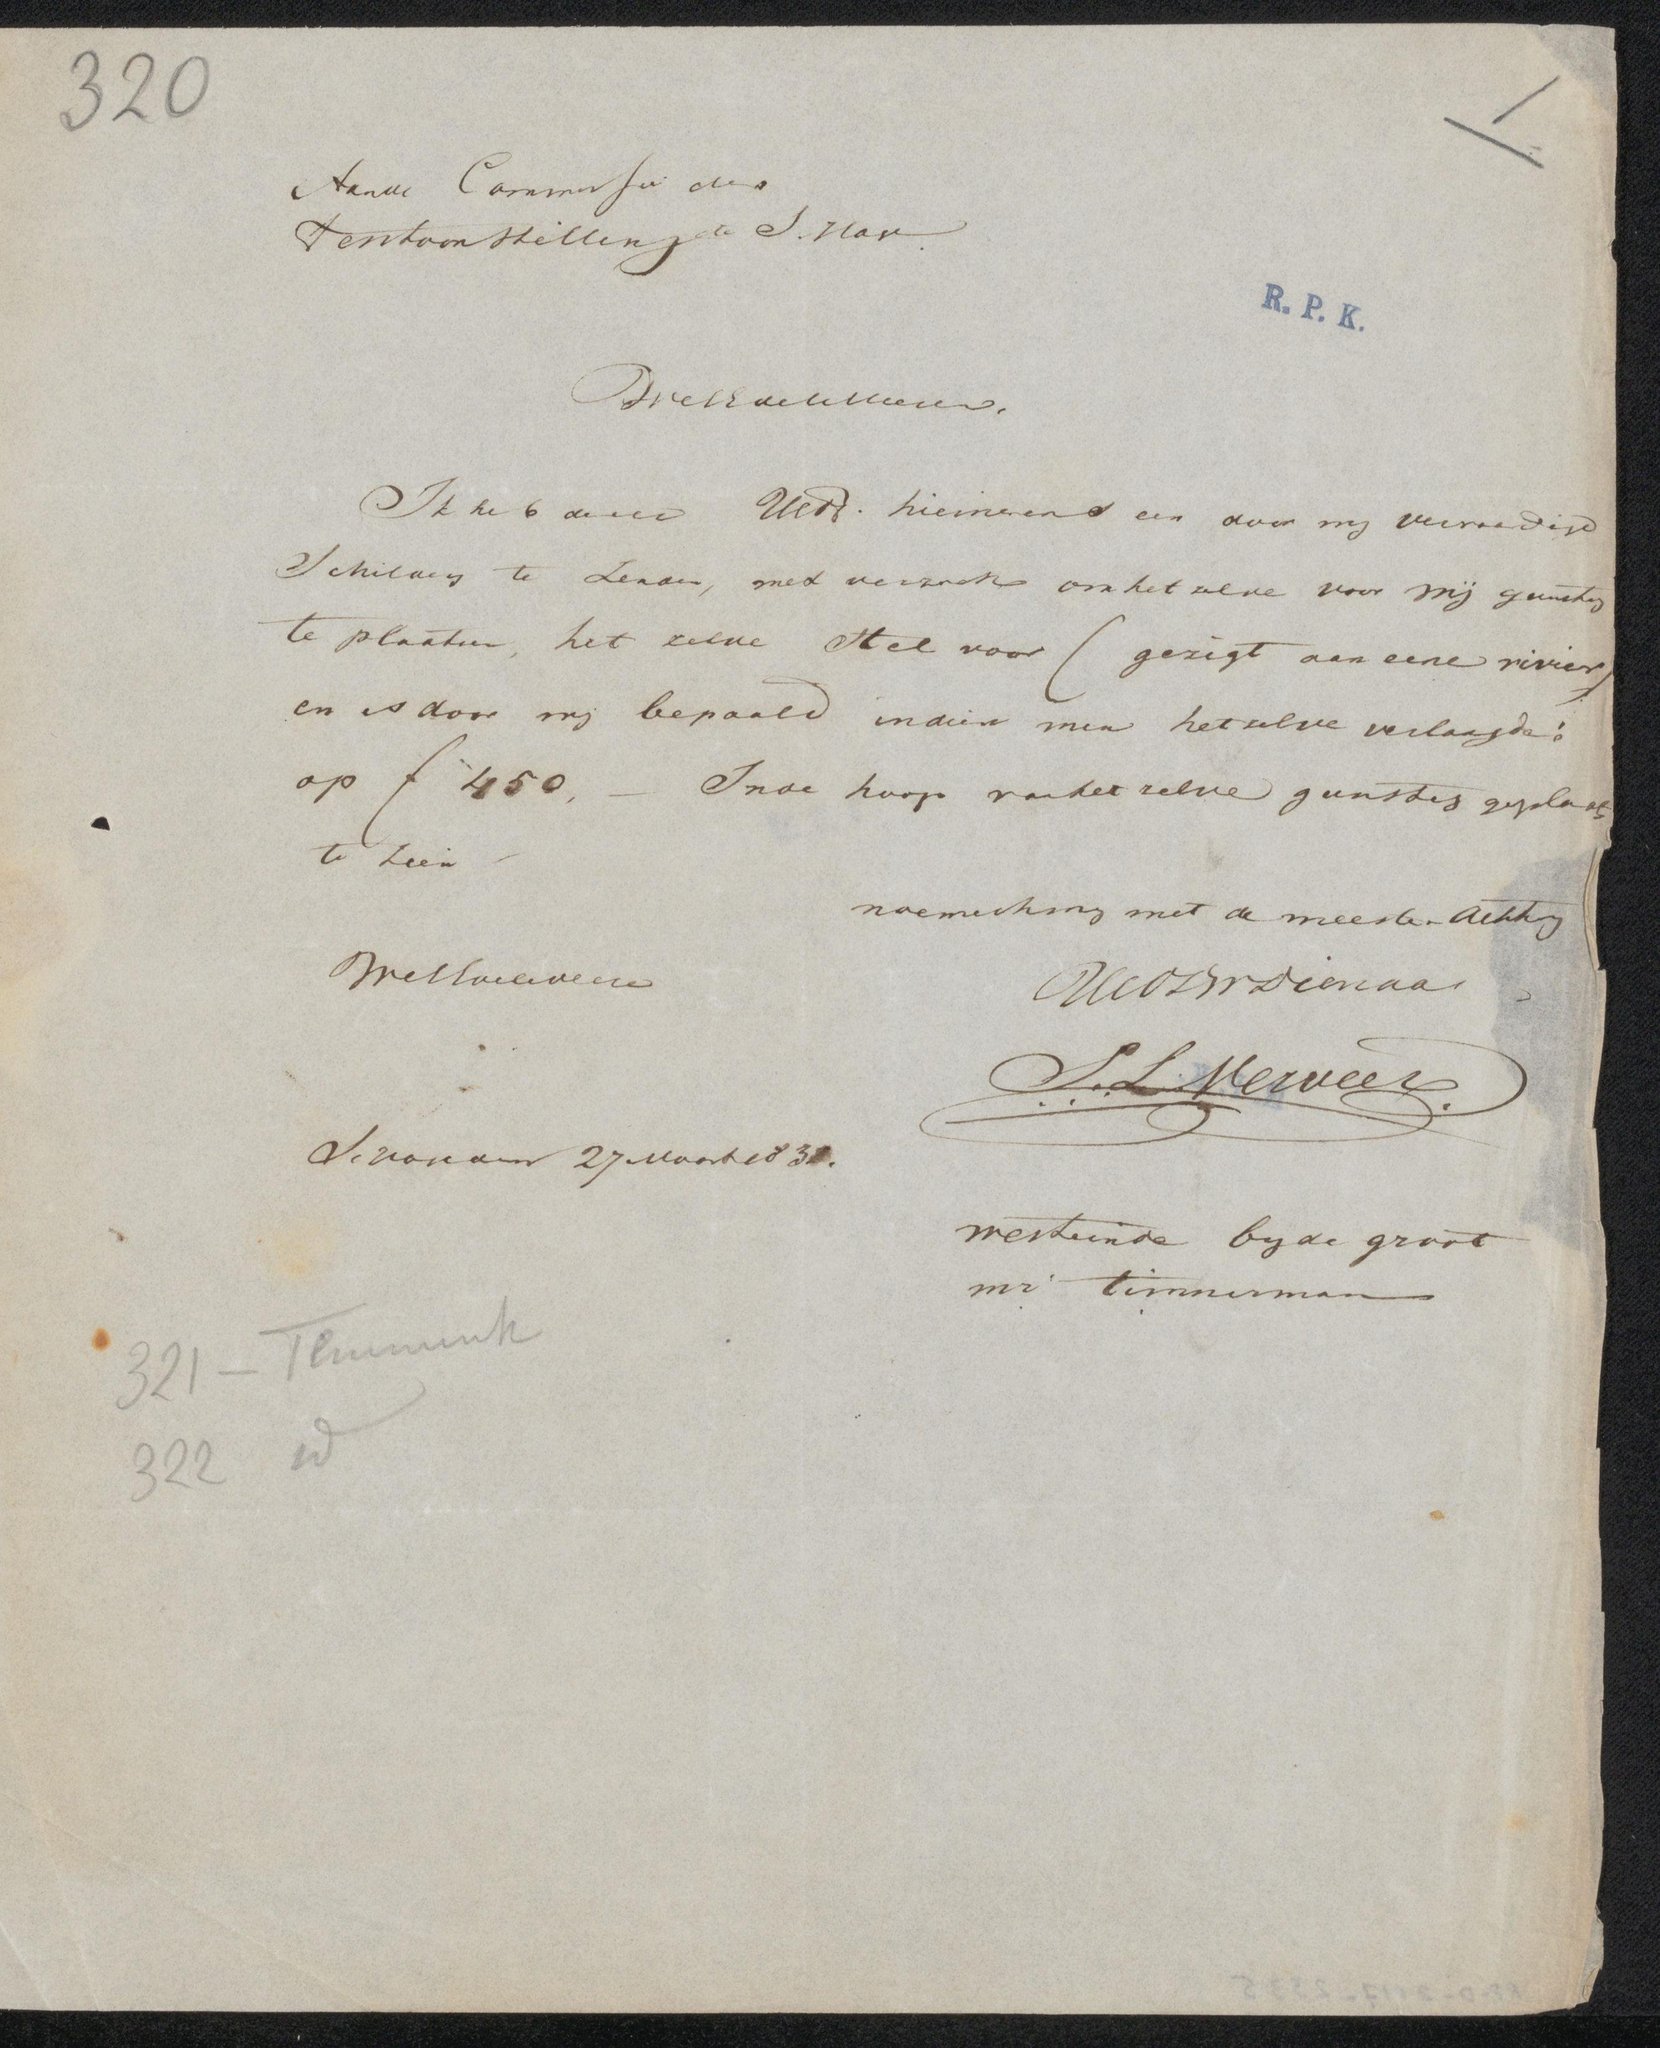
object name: letter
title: Brief aan de Commissie van de Tentoonstelling van Levende Meesters in Utrecht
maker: salomon leonardus verveer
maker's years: 1813-1876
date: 1831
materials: ink, paper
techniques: pen, writing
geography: the hague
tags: painting (including book-illumination, miniature-painting), money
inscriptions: collector's mark: Lugt 2233